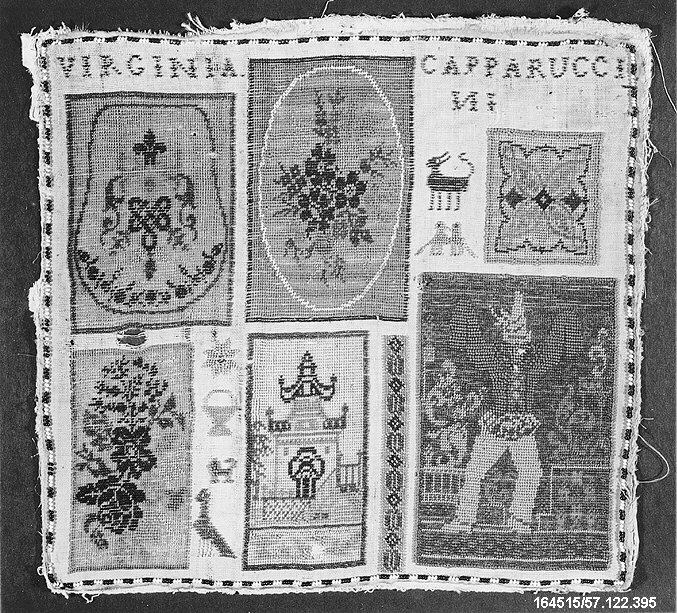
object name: sampler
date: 1801-1900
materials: linen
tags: birds,houses,men,flowers